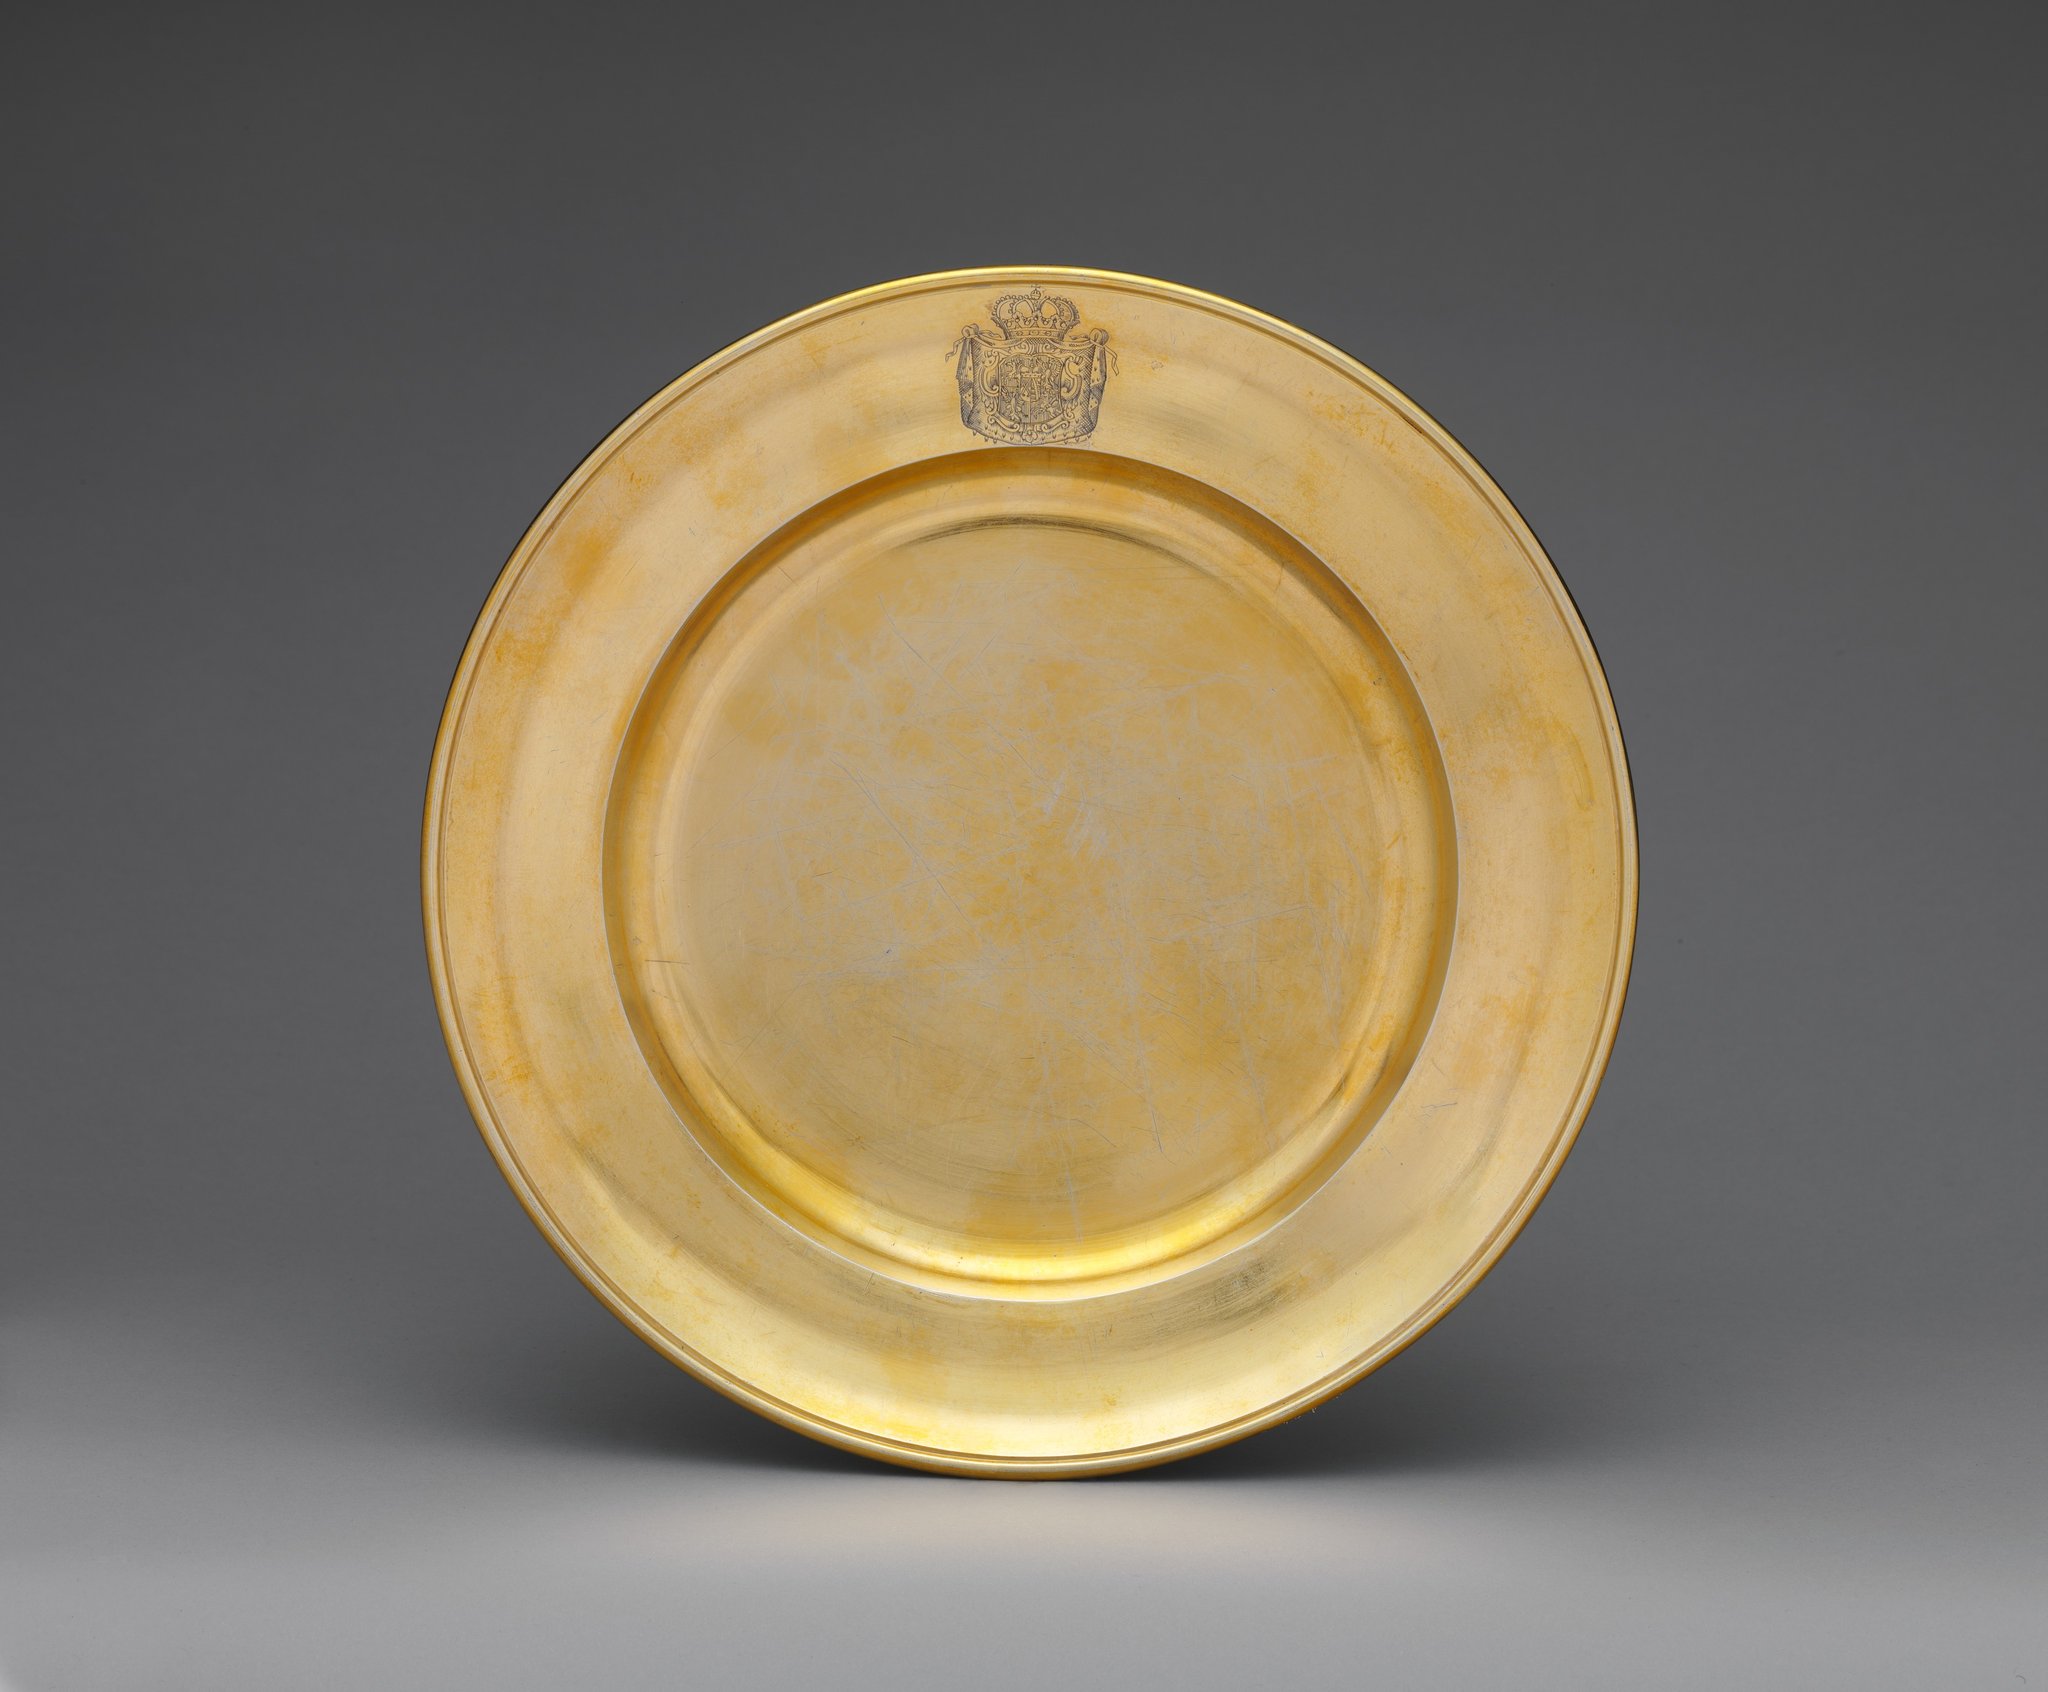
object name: plate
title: Plate (one of two)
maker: gottlieb menzel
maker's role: maker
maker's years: 1676-1757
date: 1730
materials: silver gilt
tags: coat of arms